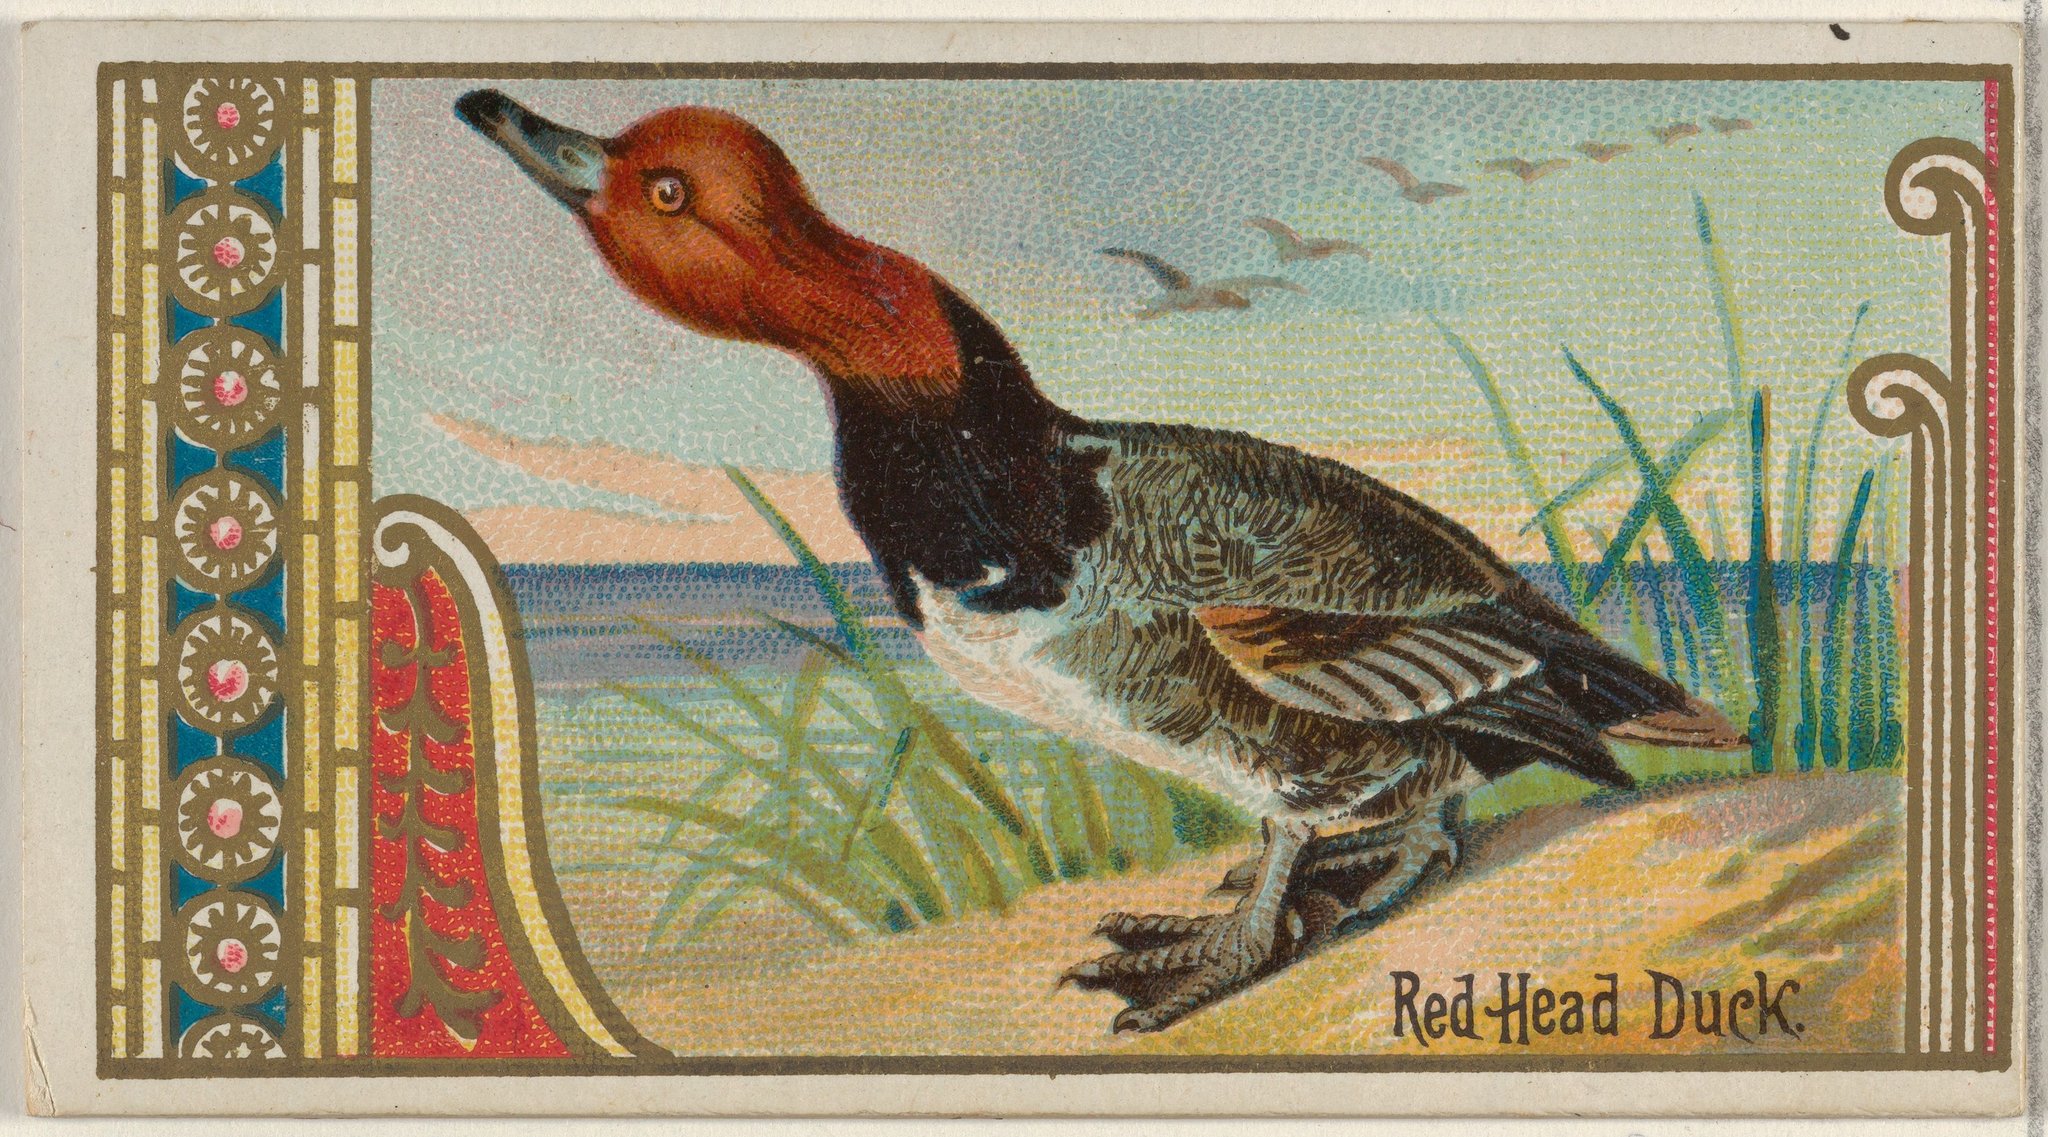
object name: print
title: Red Head Duck, from the Game Birds series (N13) for Allen & Ginter Cigarettes Brands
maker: allen & ginter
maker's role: publisher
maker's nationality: american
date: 1889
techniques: color lithograph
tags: ducks